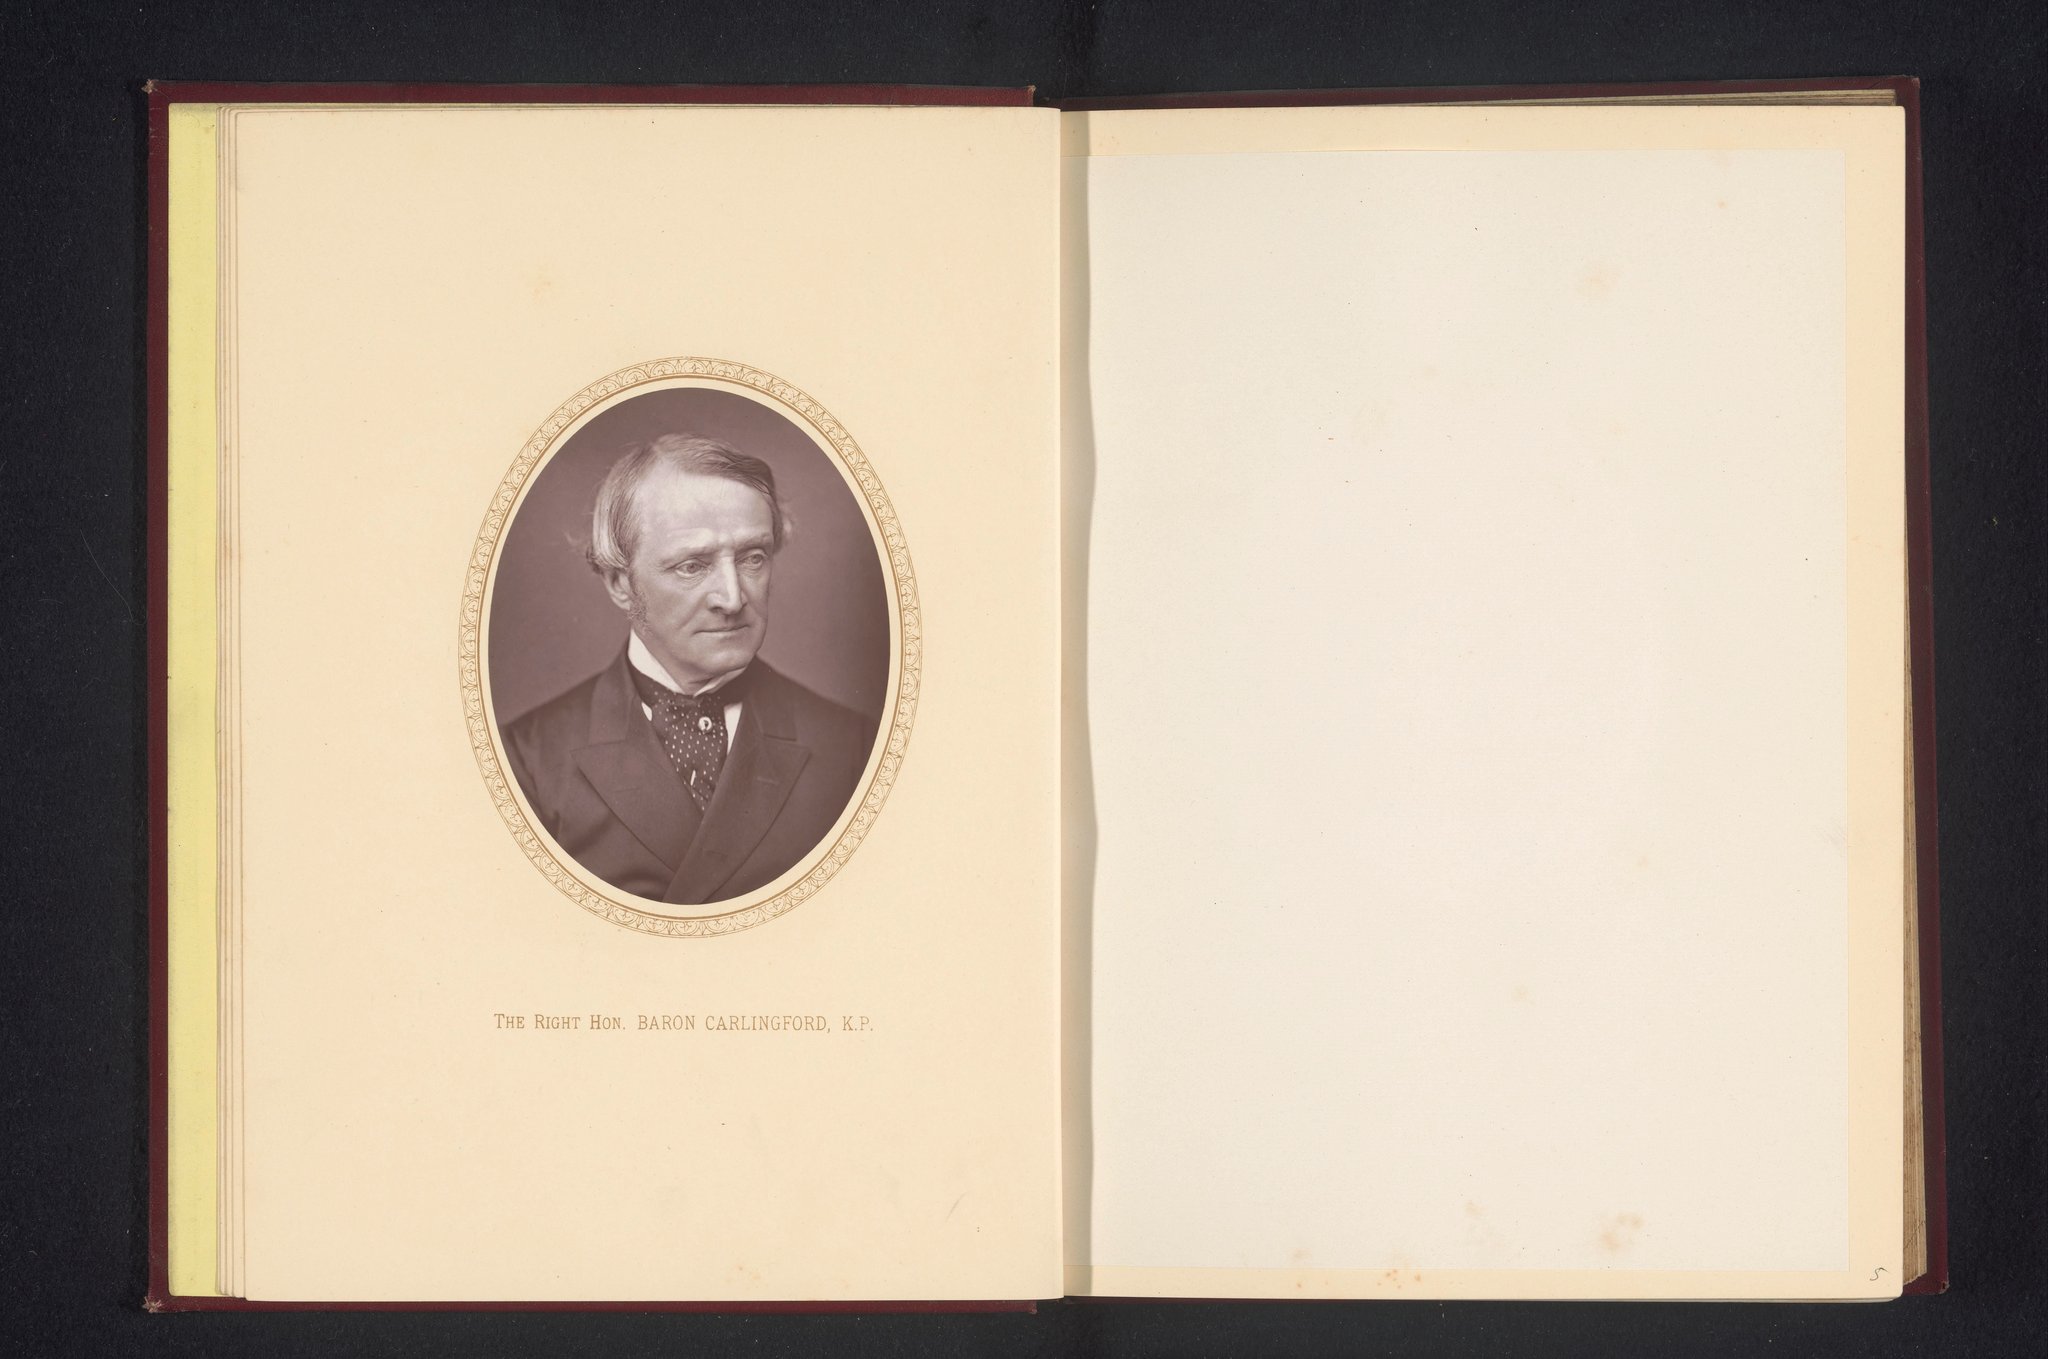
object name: page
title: The right hon. baron Carlingford, K.P.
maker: Anonymous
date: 1875-1880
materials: paper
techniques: woodburytype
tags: politician, politician, e.g. party leader